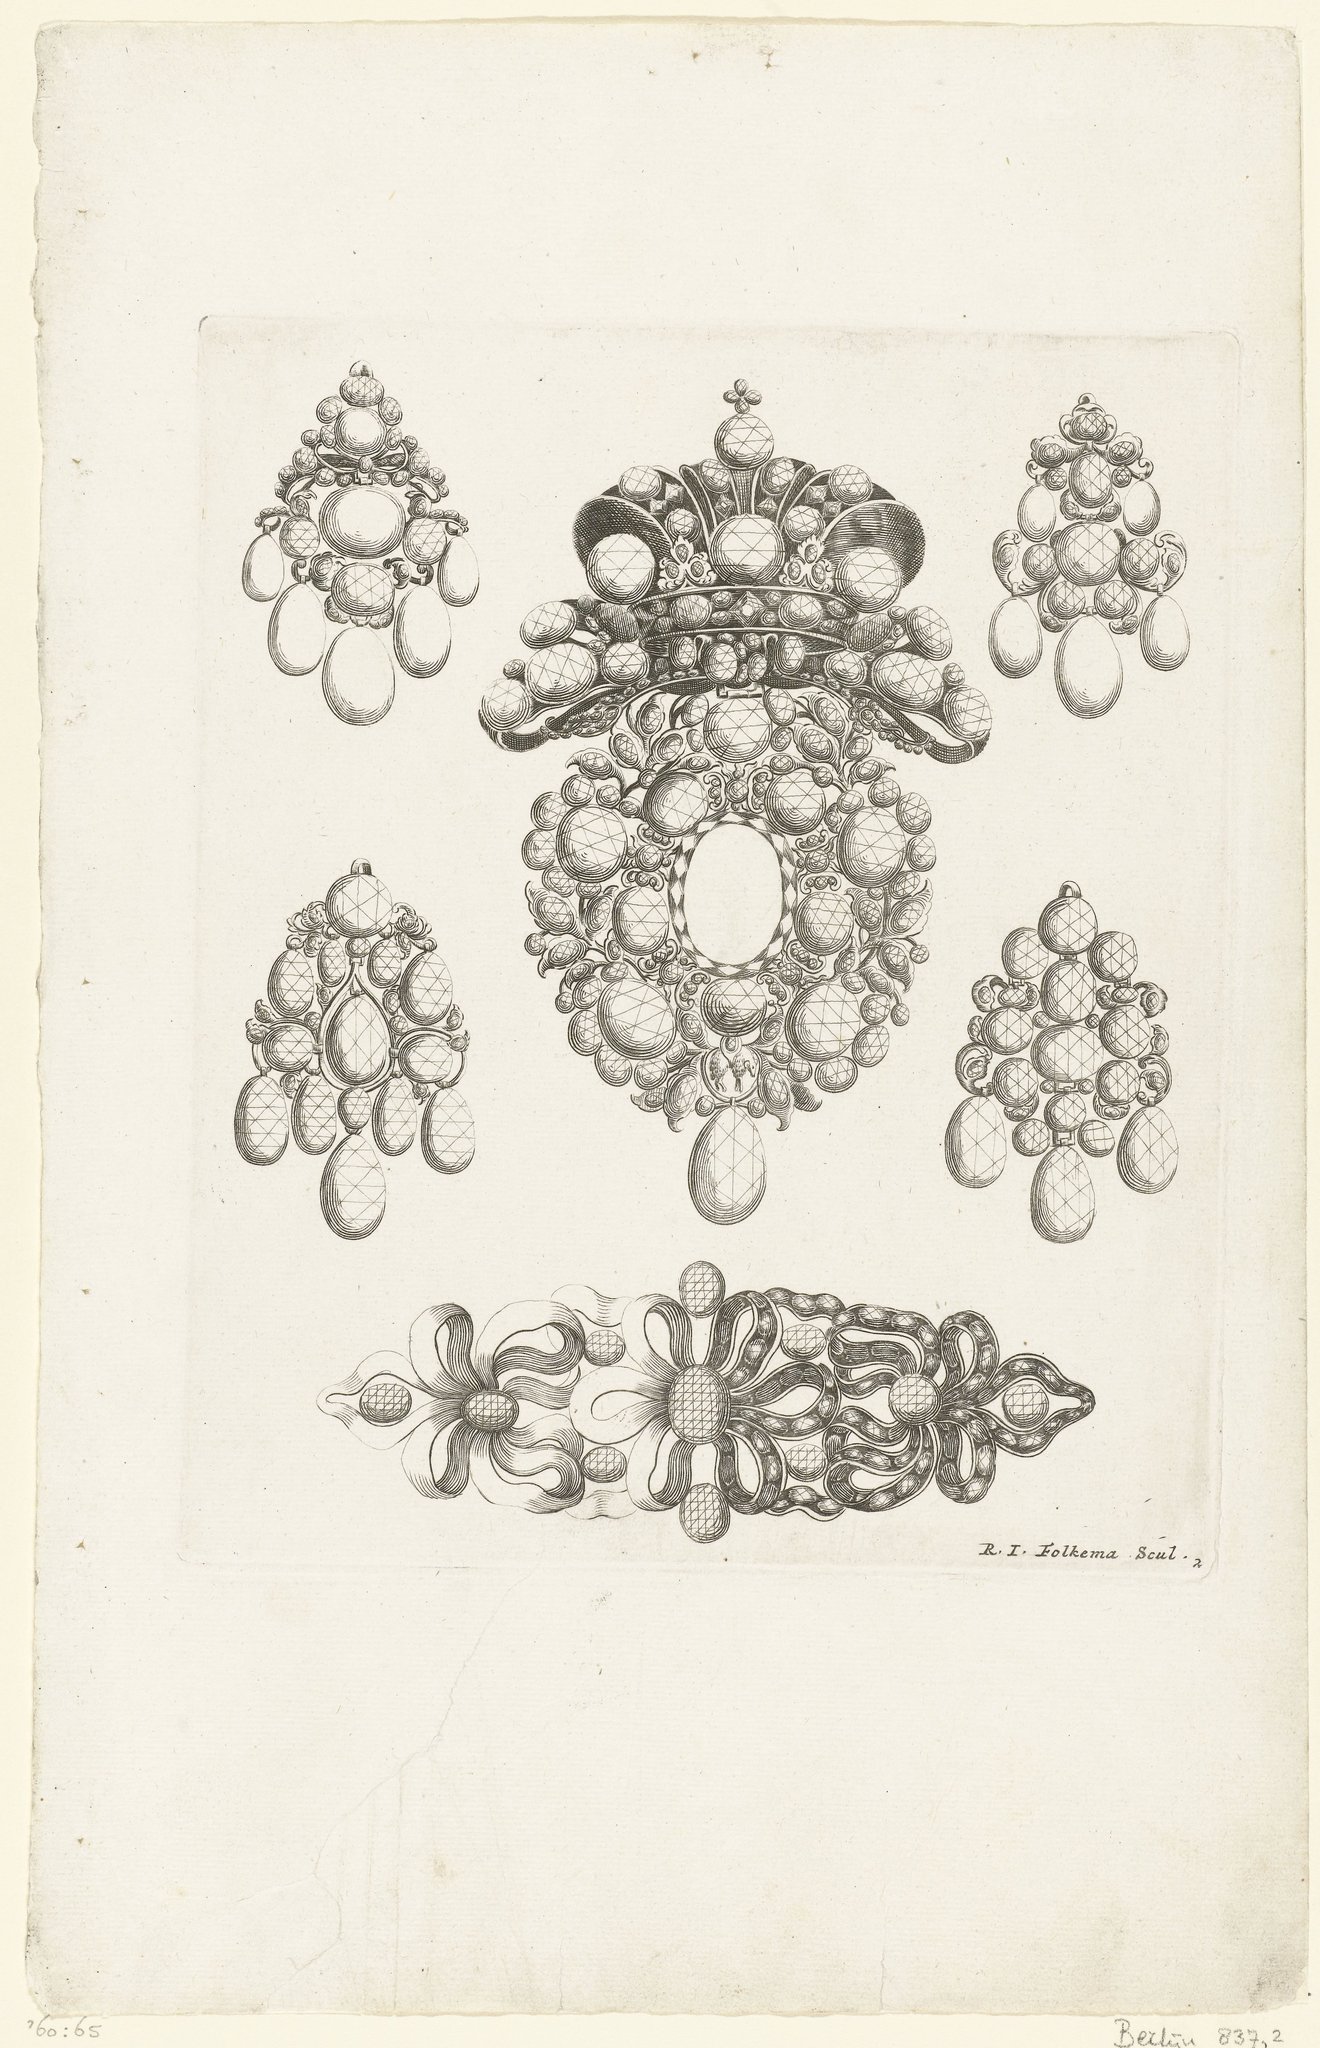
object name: ornament print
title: Liure de Feuillages et d'Ouvrages d'Orfevrerie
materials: paper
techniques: engraving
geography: amsterdam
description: Vier hangers met edelstenen en parels, een grotere hanger met een gesloten kroon en een broche. Blad 2 uiit serie met bladranken en ontwerpen voor edelsmeden, Nederlandse kopieën van ontwerpen door Thomas Lejuge, Jean Louis Durant en Friedrich Jacob Morisson. Tweede editie.